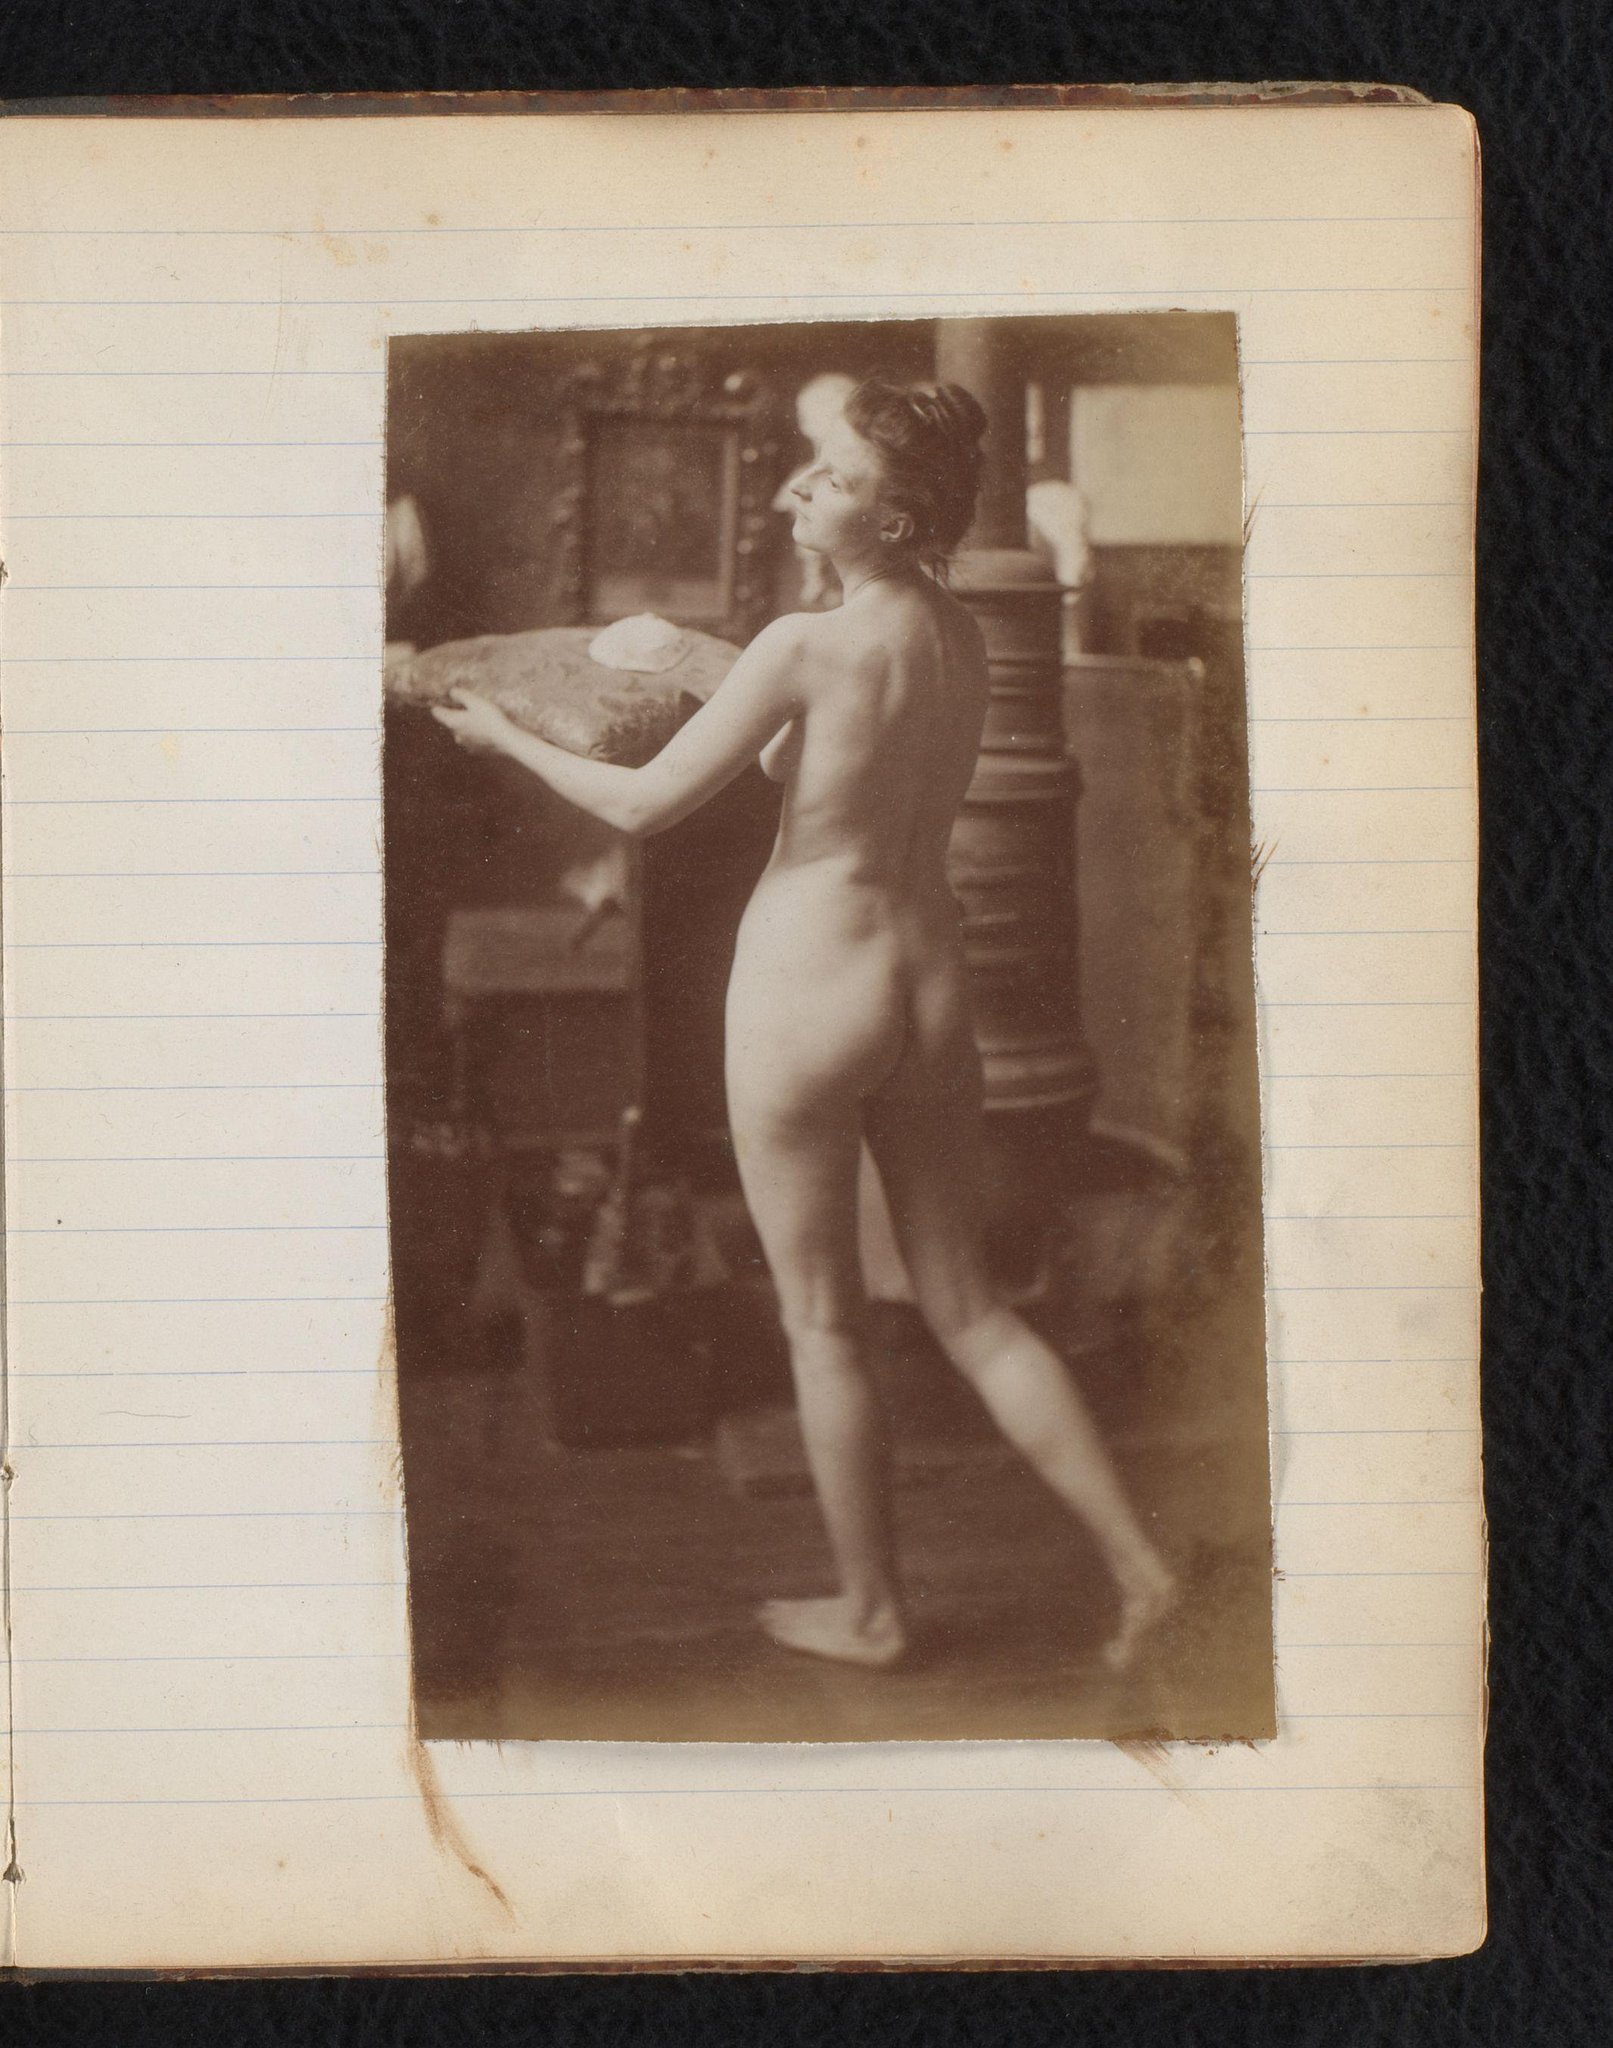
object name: album leaf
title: Studie van een vrouwelijk naaktmodel, schuin op de rug gezien, in het atelier van Jacques de Lalaing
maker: jacques lalaing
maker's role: painter, sculptor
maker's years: 1858-1917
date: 1883-1914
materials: photographic support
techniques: albumen print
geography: brussels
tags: adult woman, artist (in general) working from nude model, the (nude) human figure; 'corpo humano' (ripa) (+ back view)